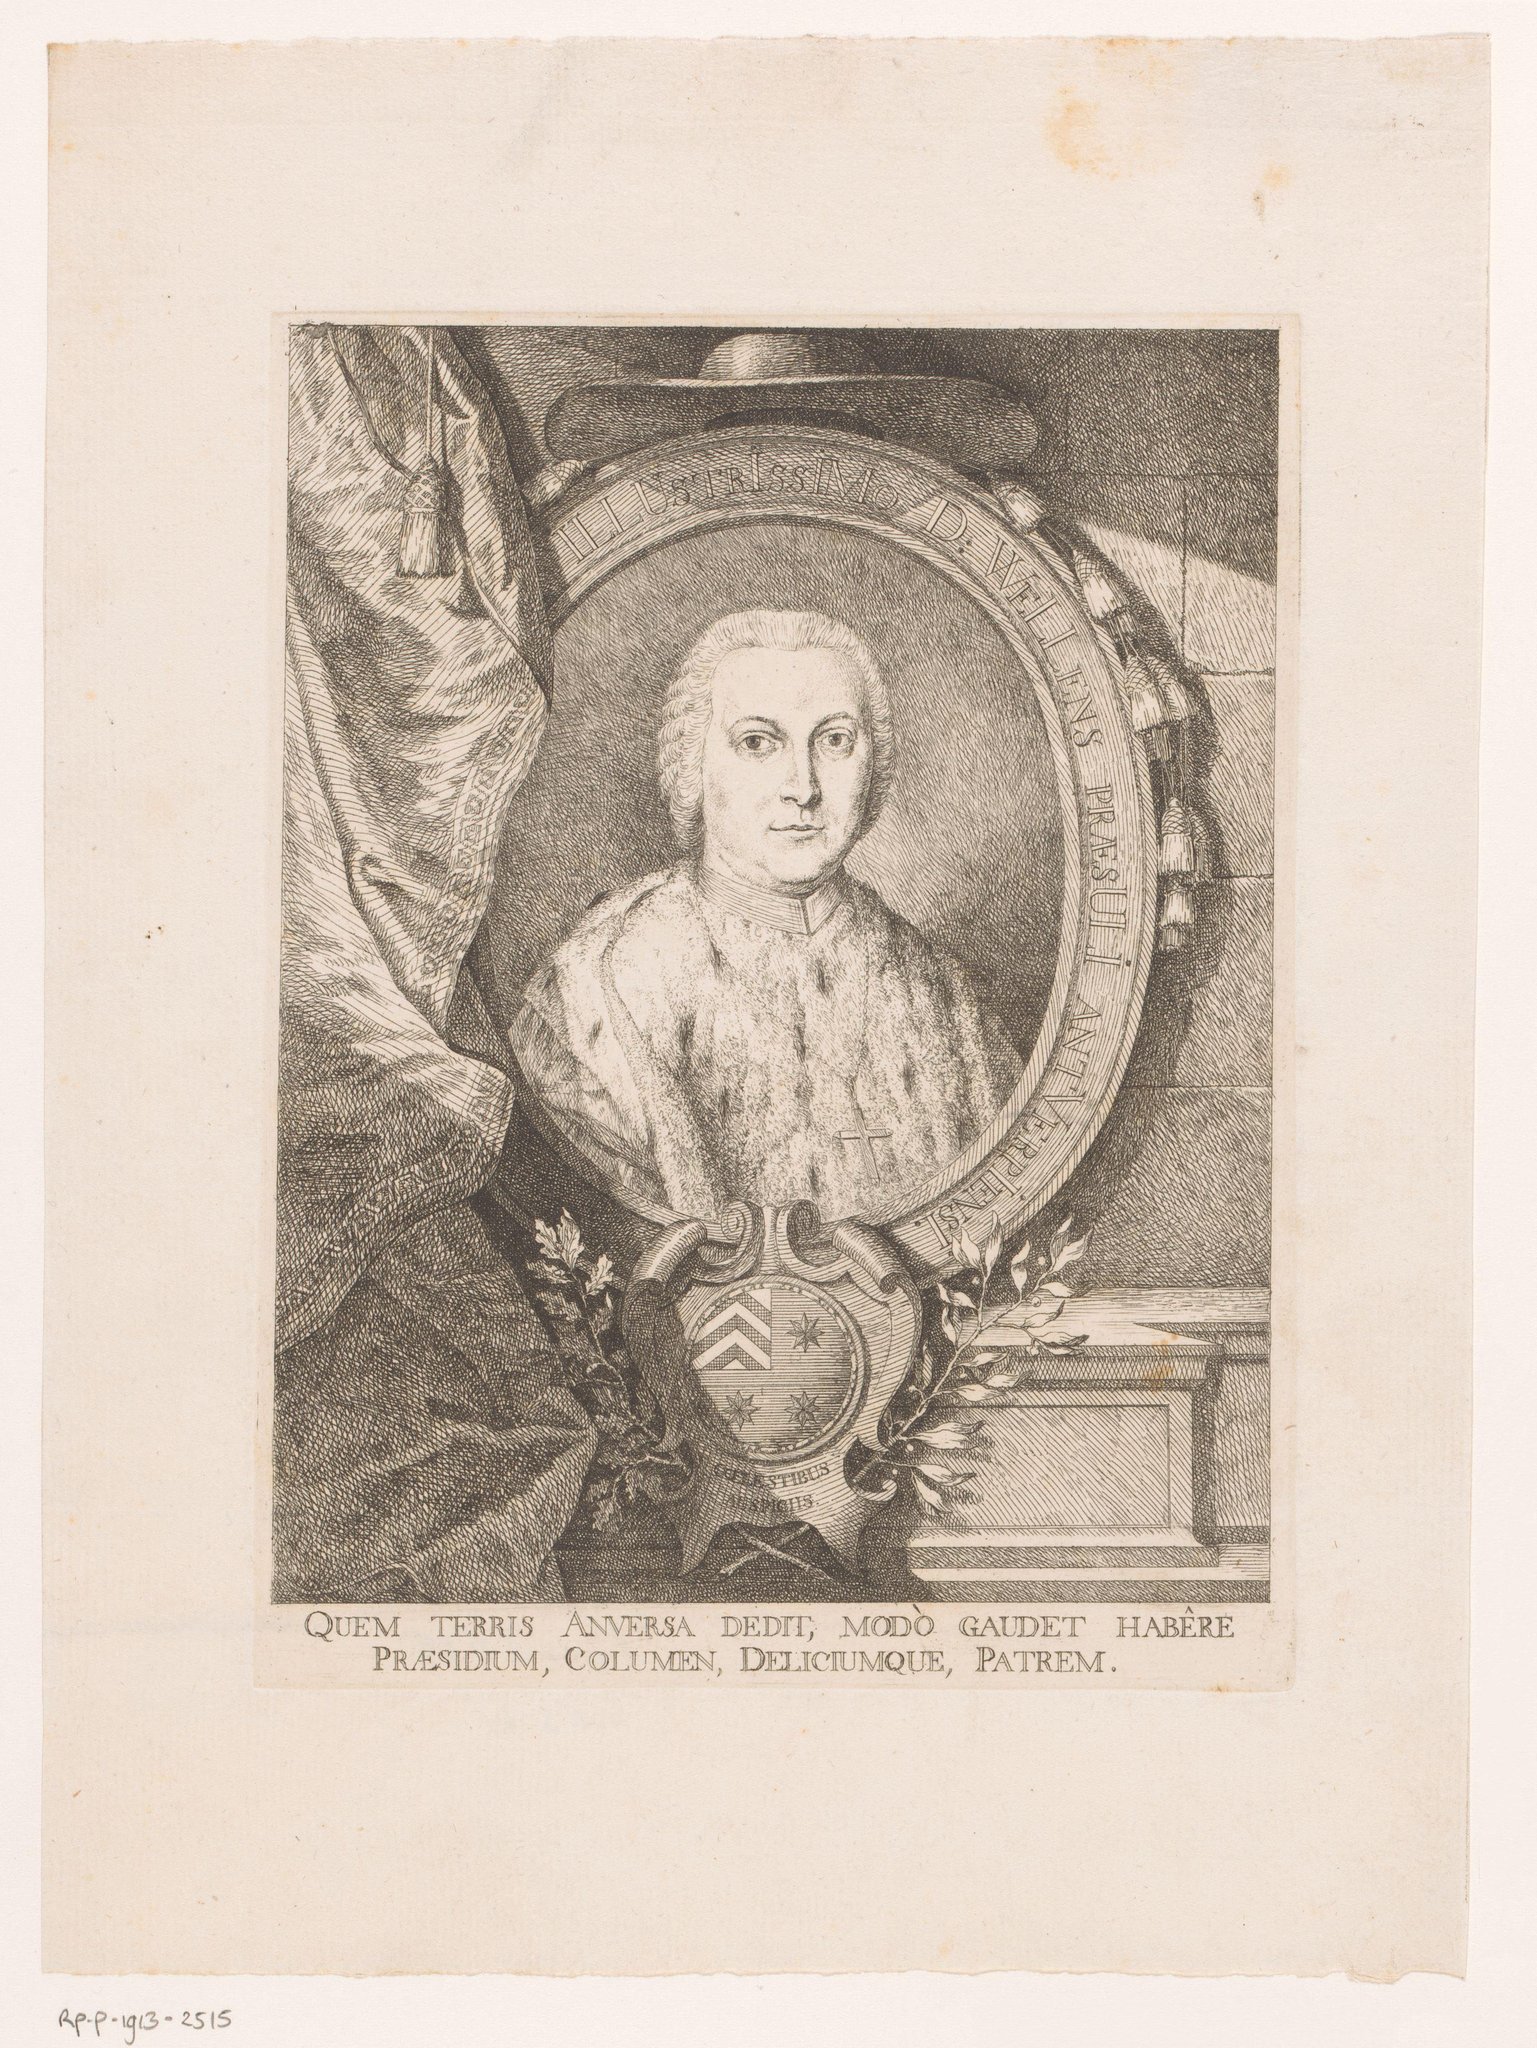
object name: print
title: Portret van Jacob Thomas Jozef Wellens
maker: andreas bernardus de quertenmont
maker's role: draughtsman, print maker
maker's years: 1750-1835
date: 1760-1835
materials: paper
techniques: etching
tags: priest, historical persons, insignia of cardinal, e.g. hat, mantle, armorial bearing, heraldry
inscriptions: collector's mark: Lugt 2228, collector's mark: Lugt 1485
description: Jacob Thomas Jozef Wellens was bisschop te Antwerpen. Bovenaan het kader is een kardinaalshoed afgebeeld; onderaan het wapenschild van Wellens.